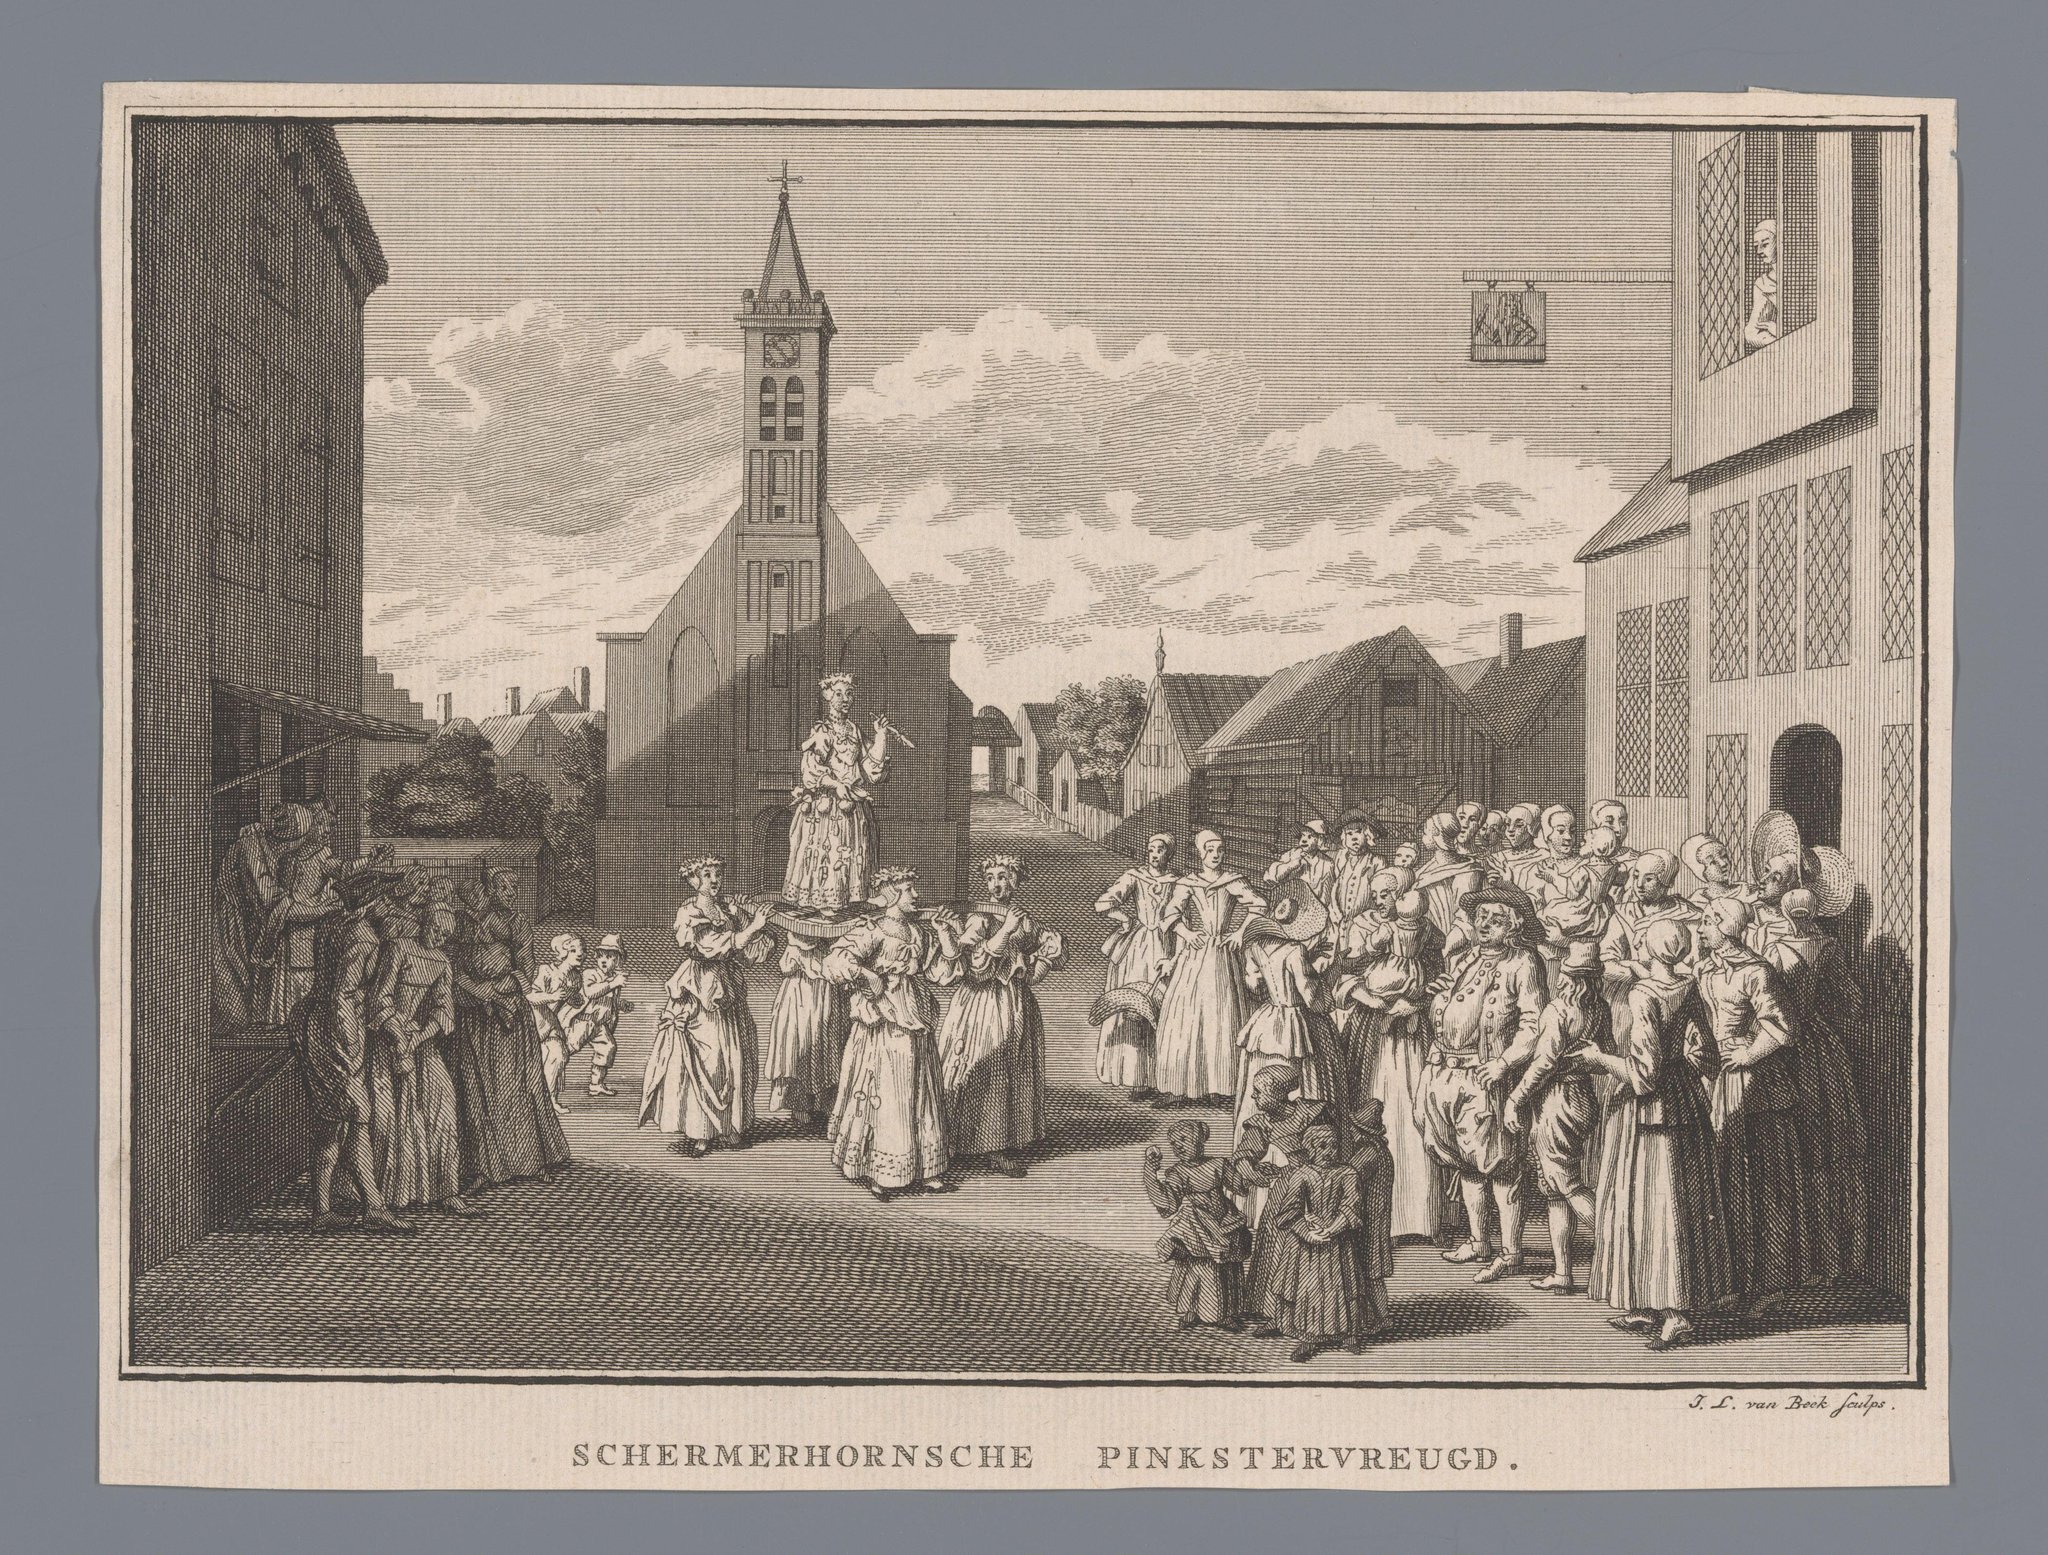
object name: print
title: Meisje met fluit (Pinksterblom) op baar gedragen door vier meisjes tijdens Pinksterfeest in Schermerhorn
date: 1763-1818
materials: paper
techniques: engraving, etching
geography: amsterdam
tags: pentecost, whitsunday, calendar festivals, non-liturgical celebrations of days belonging to the ecclesiastical calendar (+ parade, pageant, cavalcade ~ festive activities)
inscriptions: collector's mark: Lugt 2228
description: Kopie naar prent van Bernard Picard in: Moubach, A. (vertaling). Naauwkeurige beschrijving der uitwendige godtsdienstplichten, kerkzeden en gewoontens van alle volkeren der waereldt. 6 dln. 's-Gravenhage: s.n., 1736, dl. 5, p. 327. (vergelijk http://www.beeldbank-nh.nl).